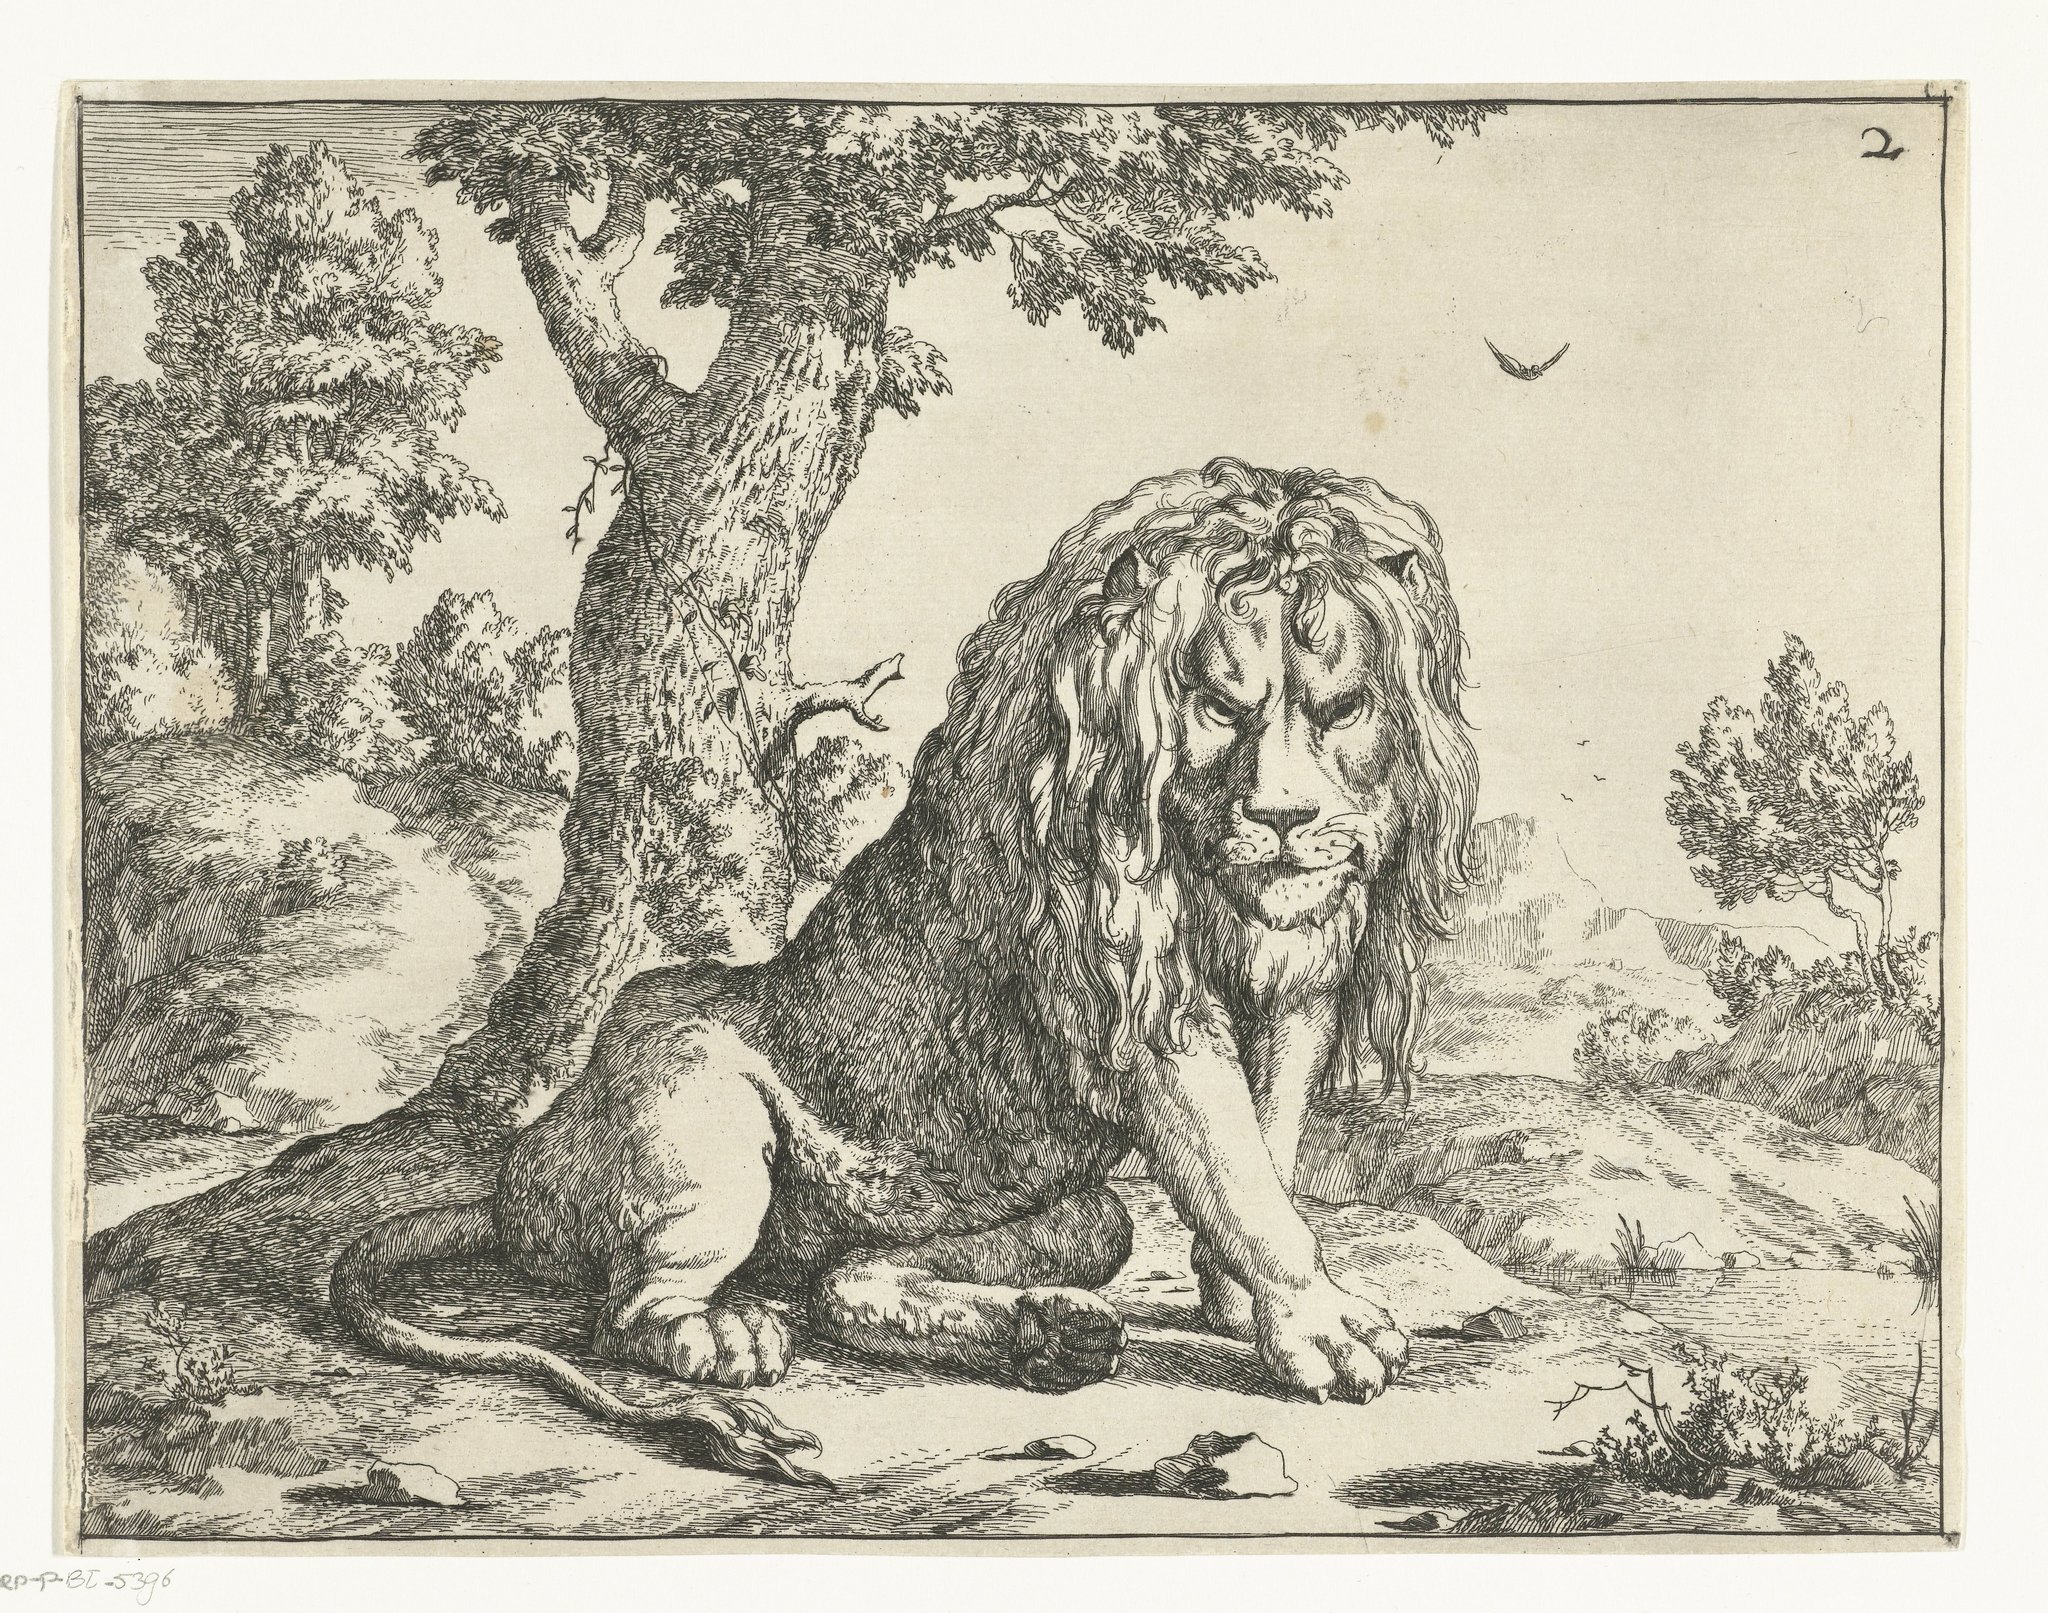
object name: print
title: Leeuw zittend bij boom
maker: marcus de bye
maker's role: print maker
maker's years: 1639-1688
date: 1664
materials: paper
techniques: etching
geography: the hague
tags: beasts of prey, predatory animals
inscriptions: collector's mark: Lugt 2228